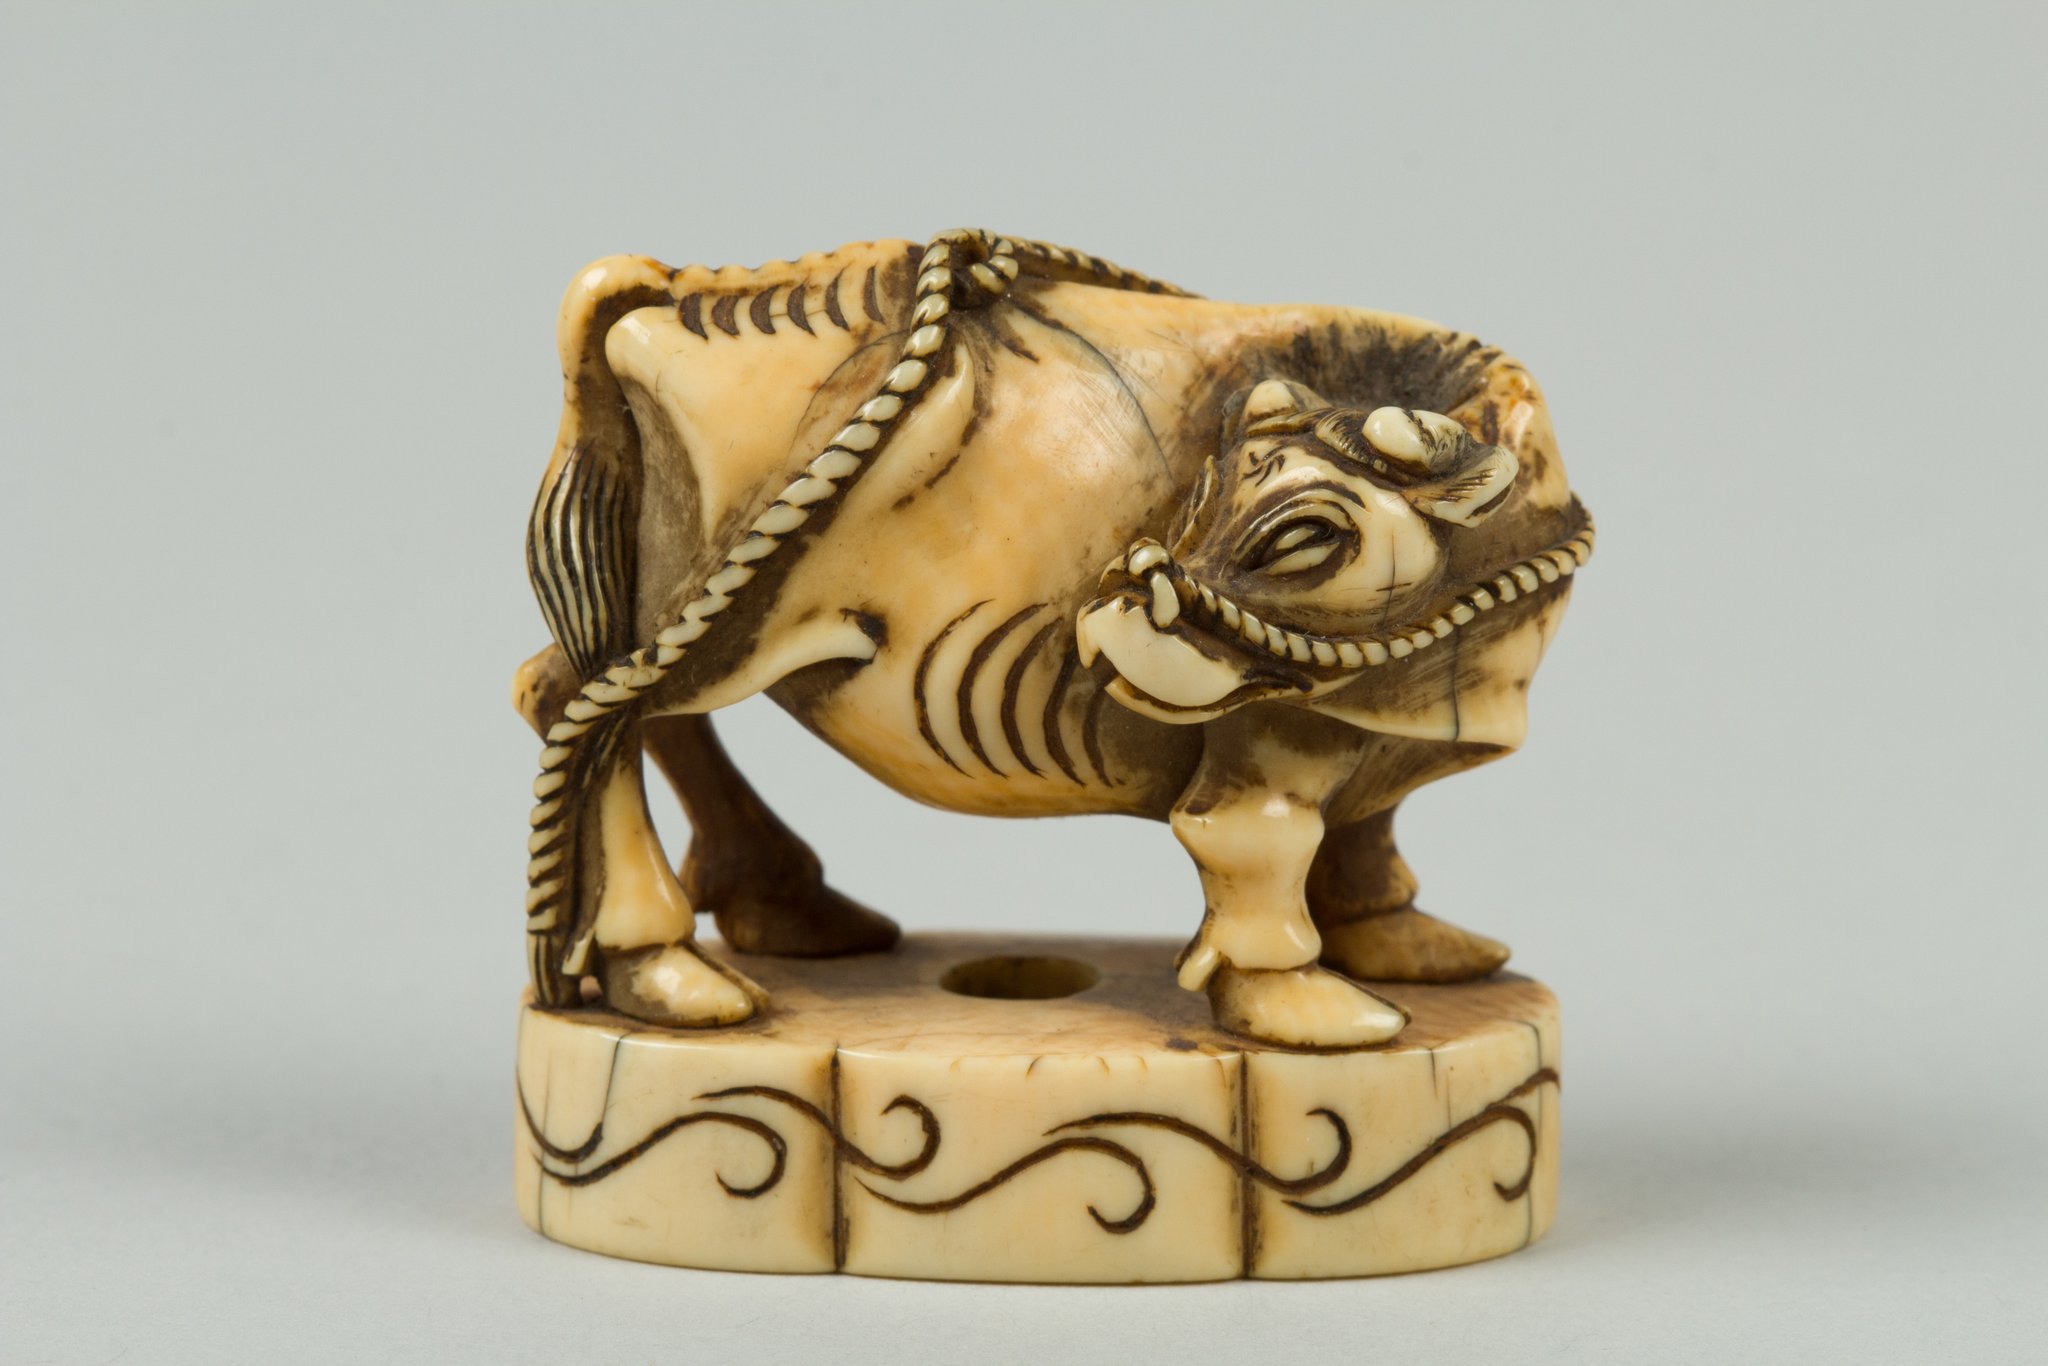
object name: netsuke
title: Netsuke of Ox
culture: japanese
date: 1801-1900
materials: ivory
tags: animals